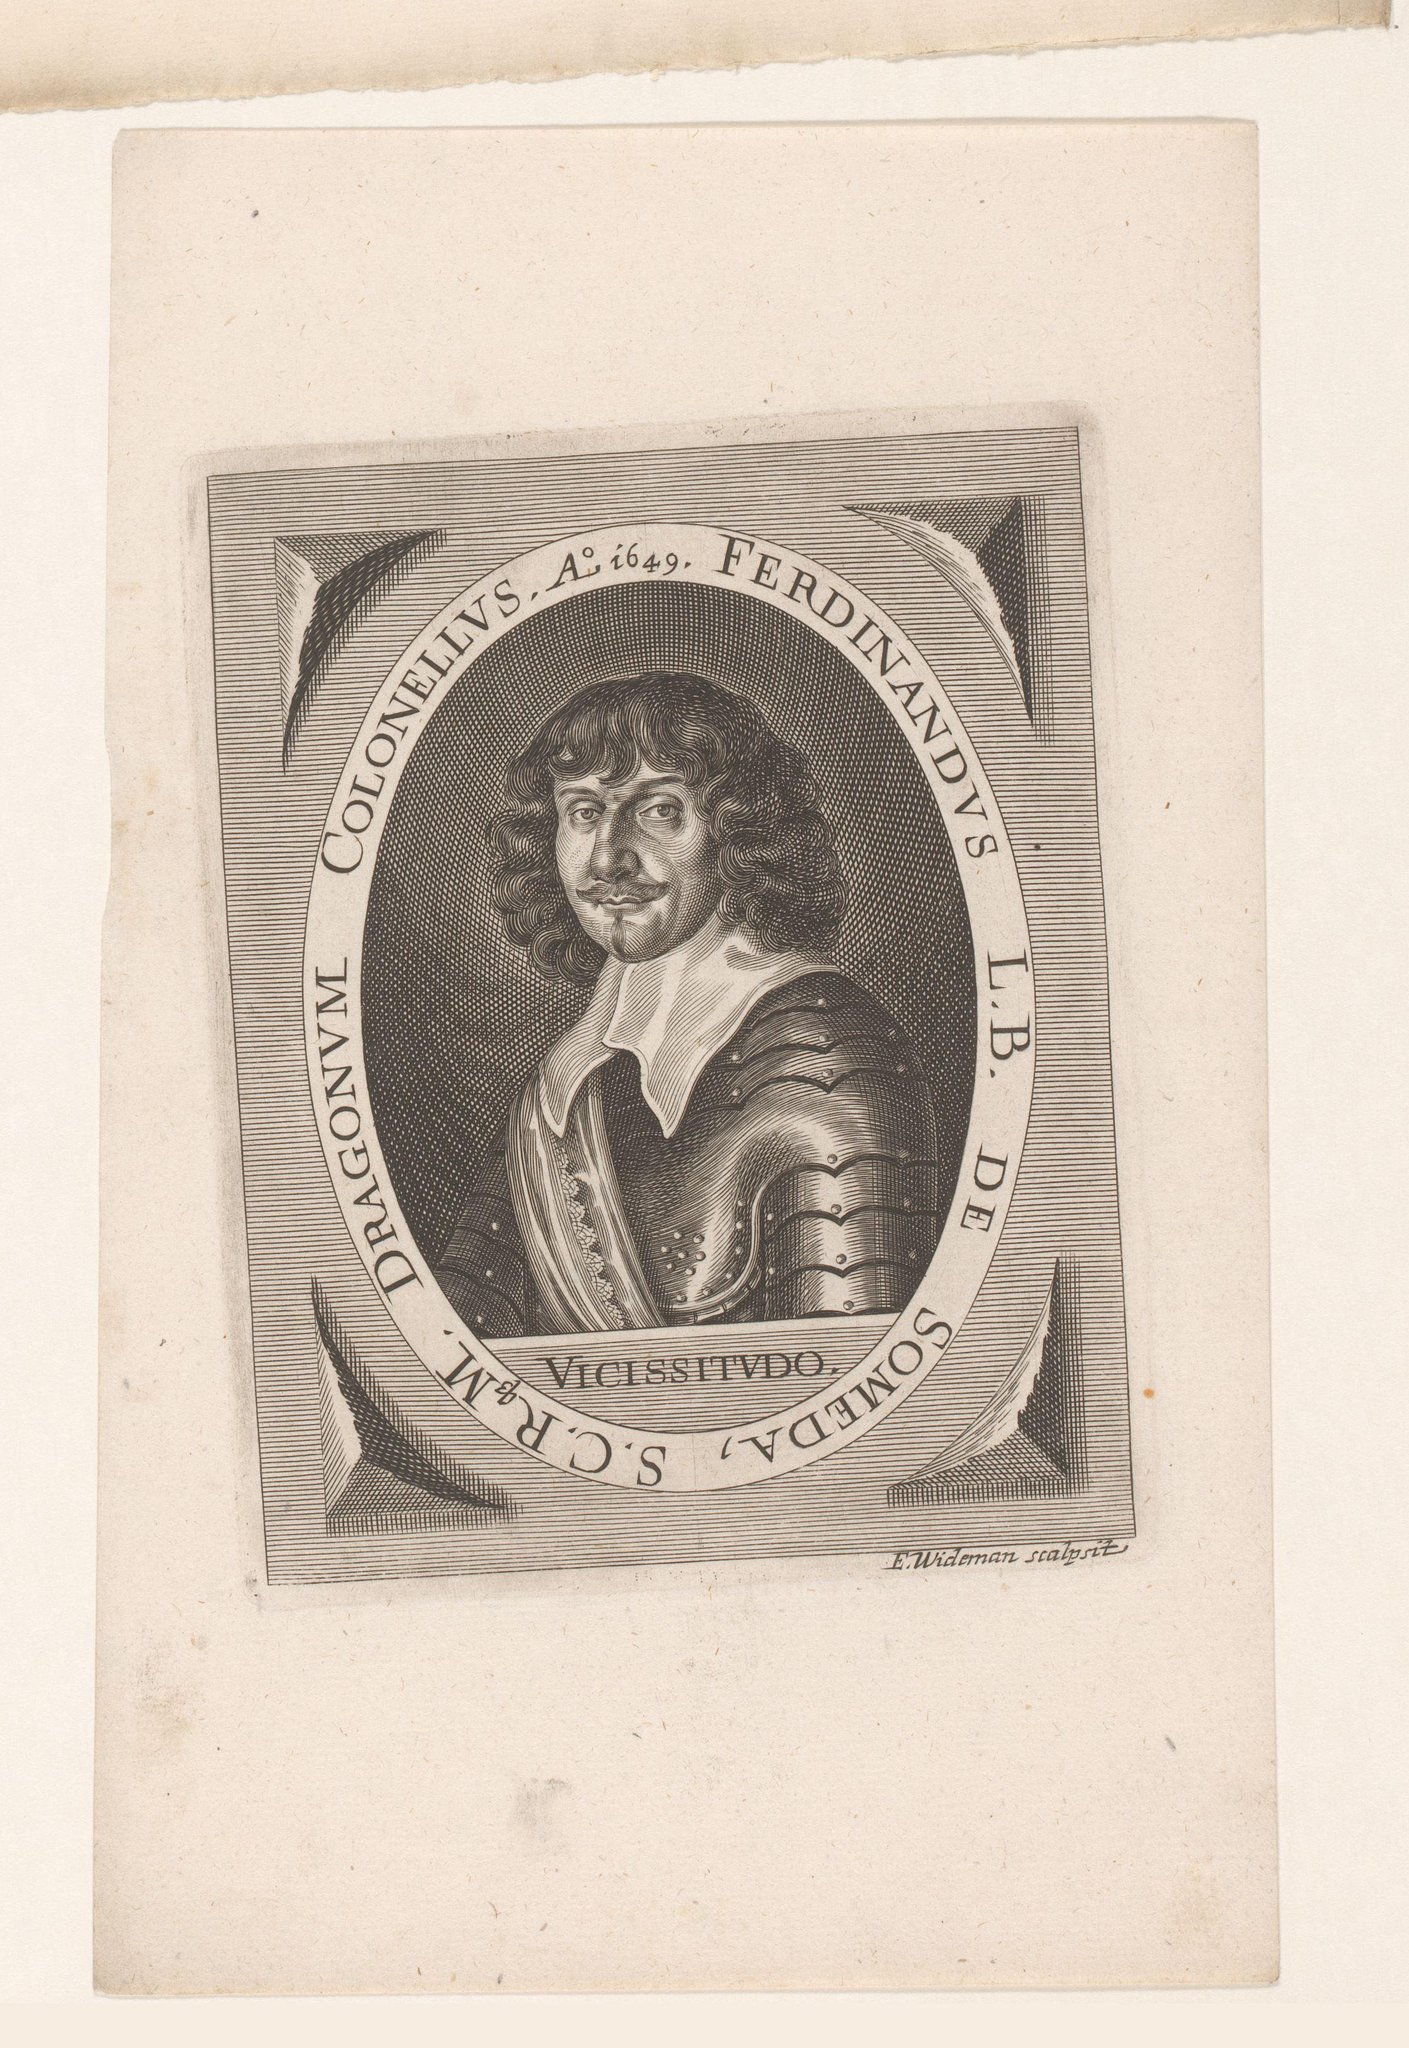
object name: print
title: Portret van Ferdinand von Someda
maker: elias widemann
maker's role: print maker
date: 1649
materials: paper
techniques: engraving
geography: vienna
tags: historical persons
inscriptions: collector's mark: Lugt 2228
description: Prent uit de publicatie: Widemann, Elias. Honori Sacrum. Wenen: s.n., 1649.